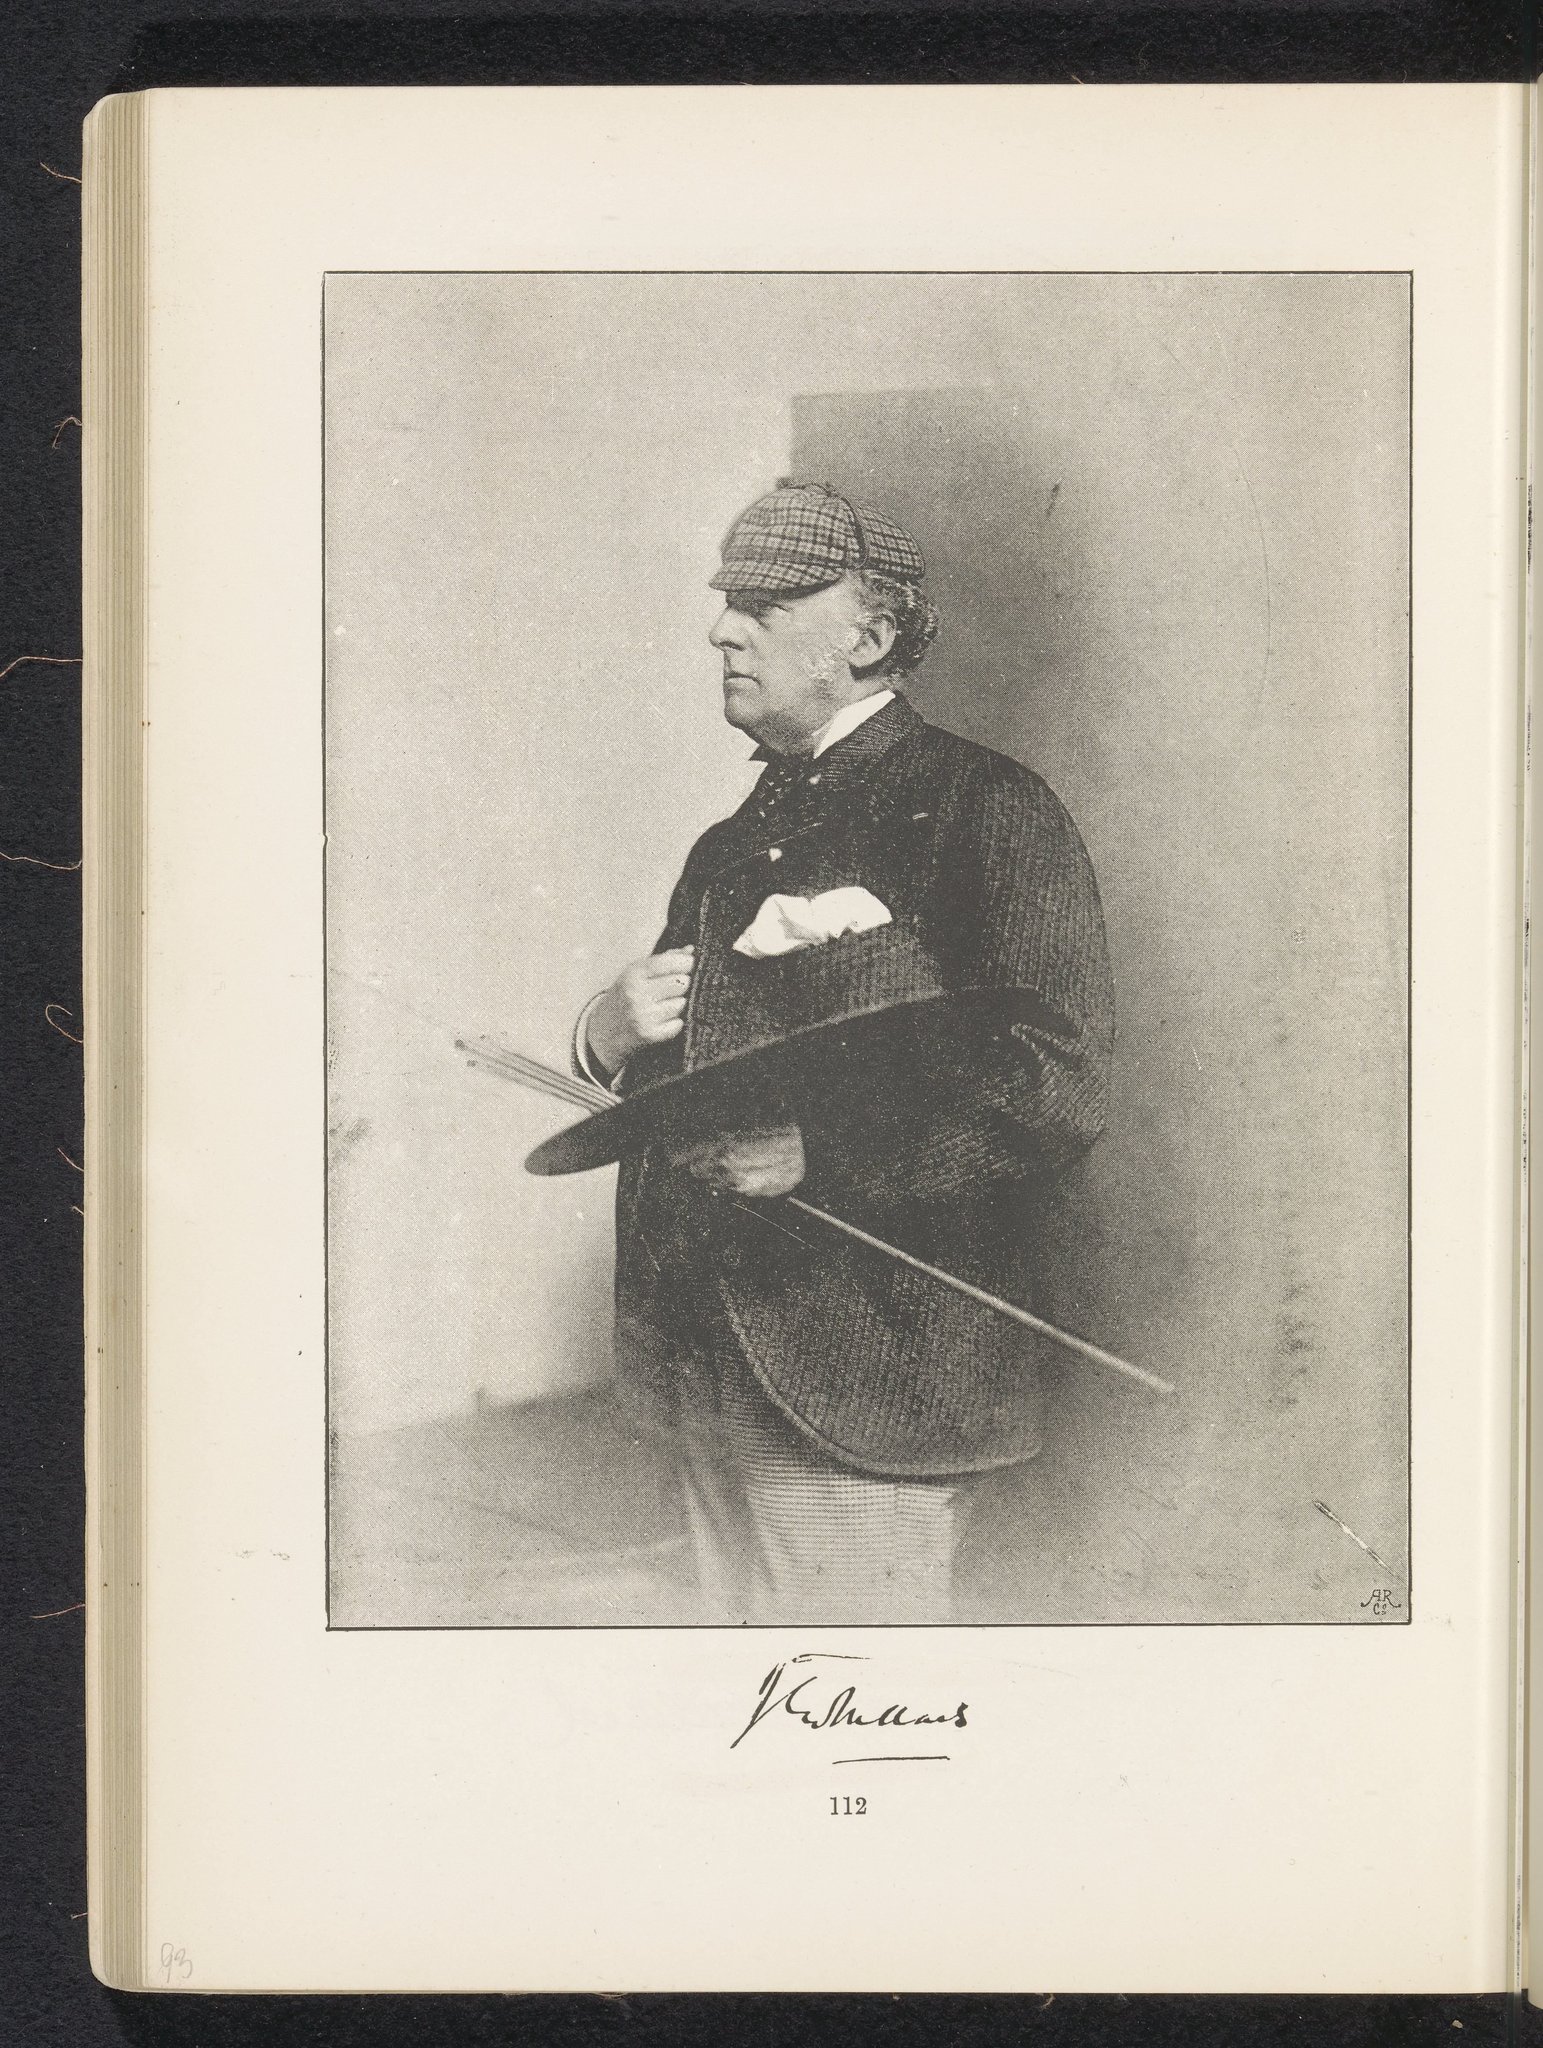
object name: photomechanical print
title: Portret van John Everett Millais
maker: Anonymous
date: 1881-1891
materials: paper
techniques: autotype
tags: london, painter, designer, john everett millais, painter at work, in his studio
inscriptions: inscription